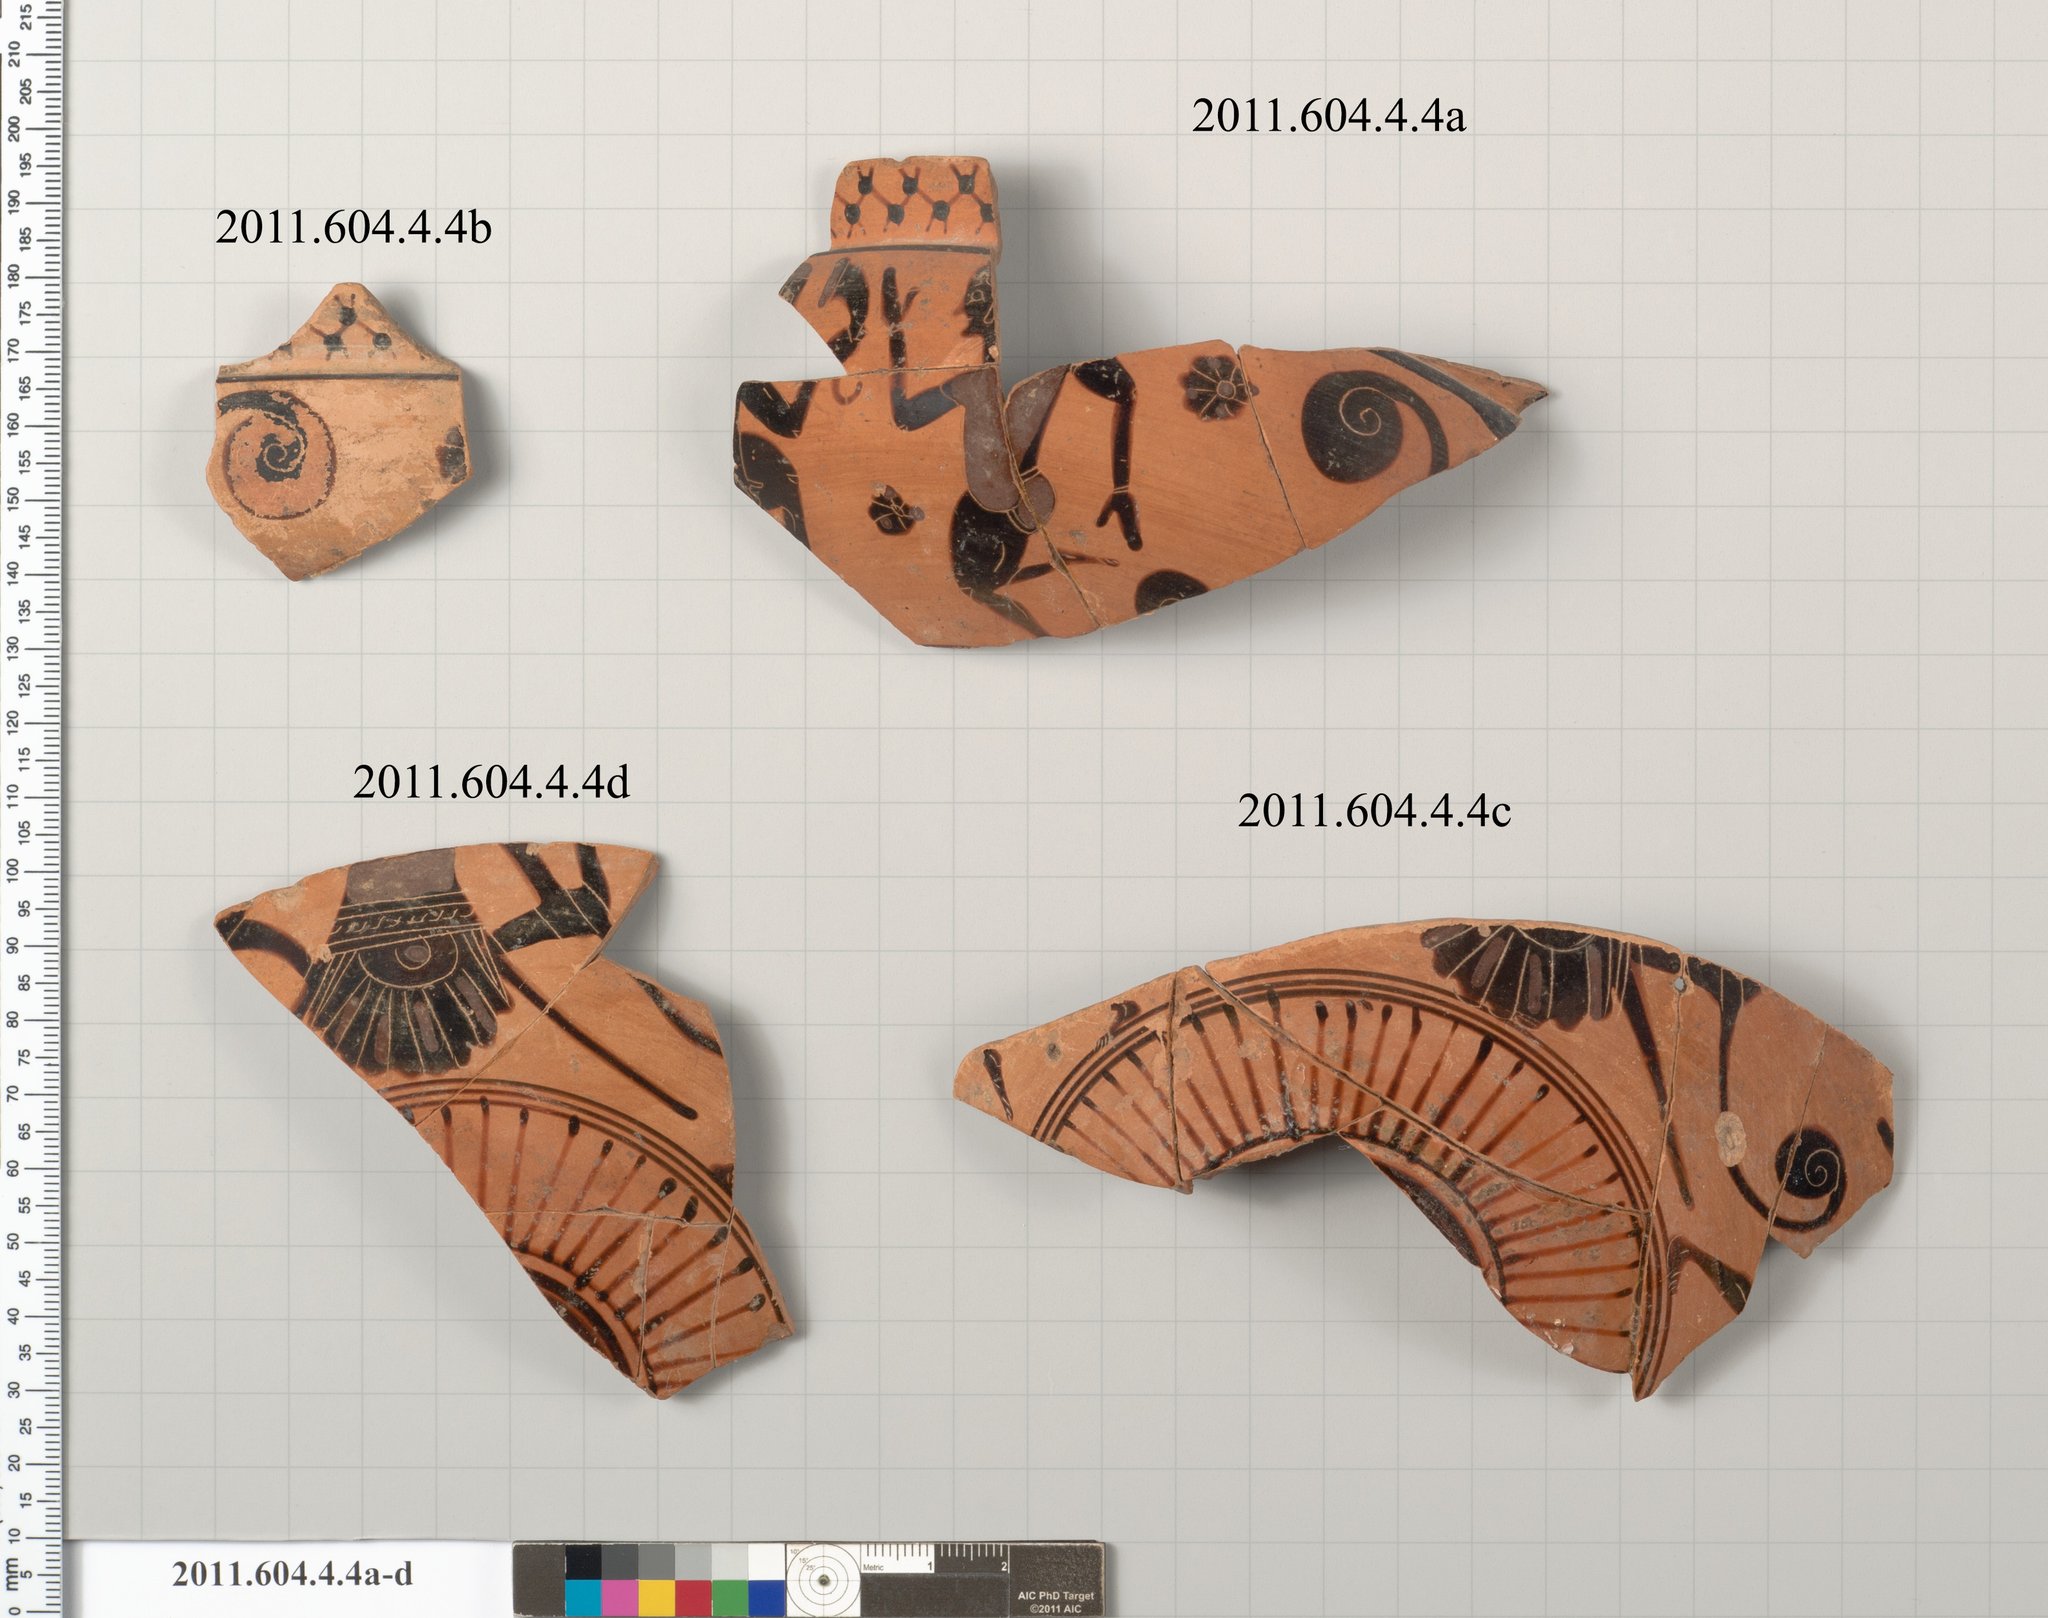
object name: kylix fragment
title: Terracotta fragments of a kylix: Komast cup (drinking cup)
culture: greek, attic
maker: falmouth painter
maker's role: artist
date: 570 BCE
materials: terracotta